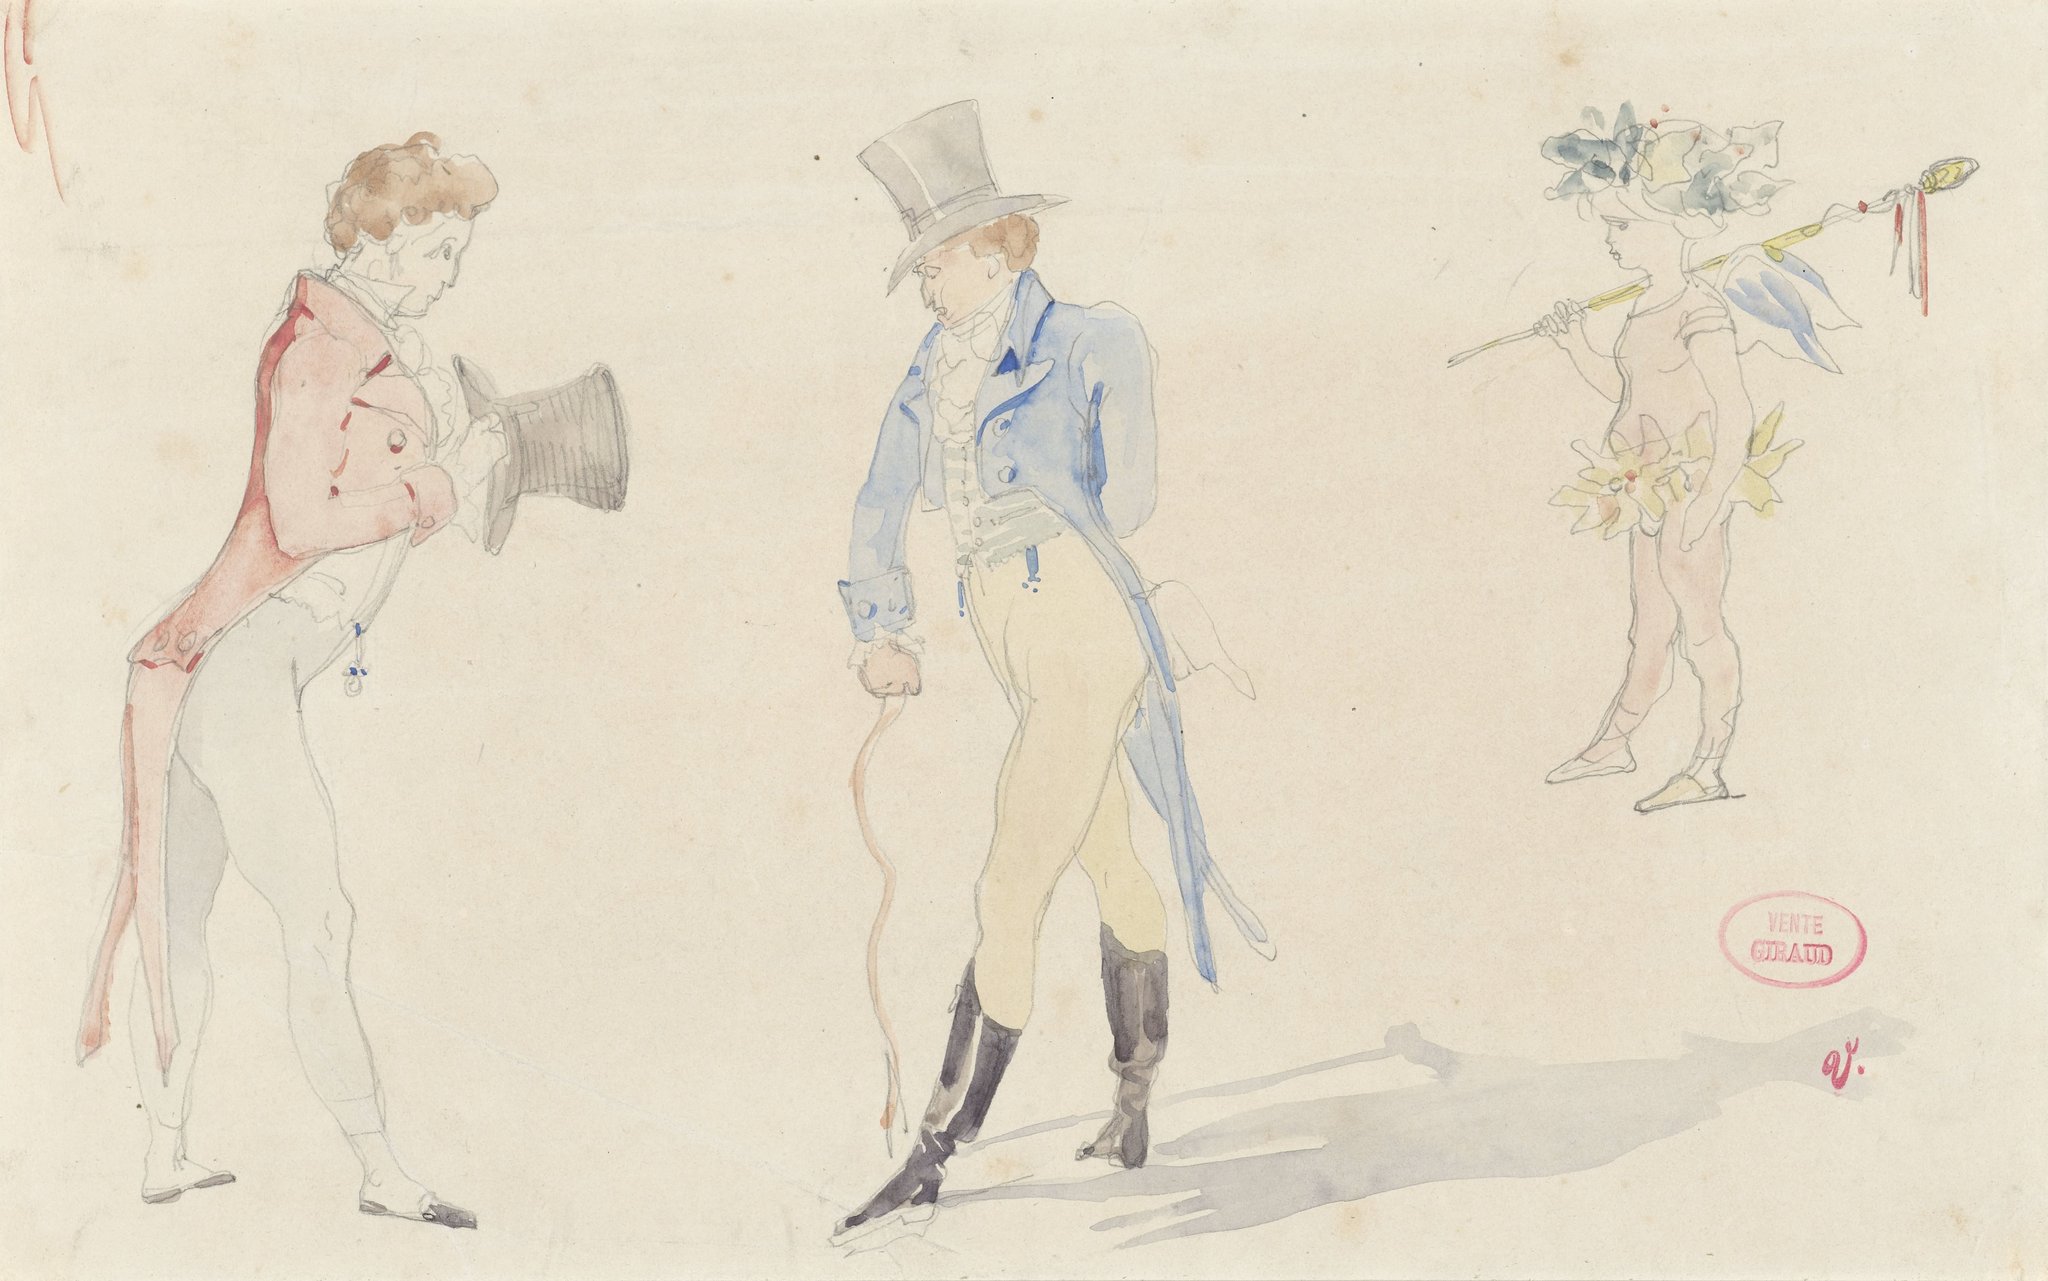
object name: drawing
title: Licht schetsblad met twee elkaar ontmoetende dandies en een ballet-amour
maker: pierre françois eugène giraud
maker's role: draughtsman, painter, print maker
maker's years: 1806-1881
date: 1816-1881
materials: paper, pencil, watercolor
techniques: brush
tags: standing figure, the ballet, ballet performance